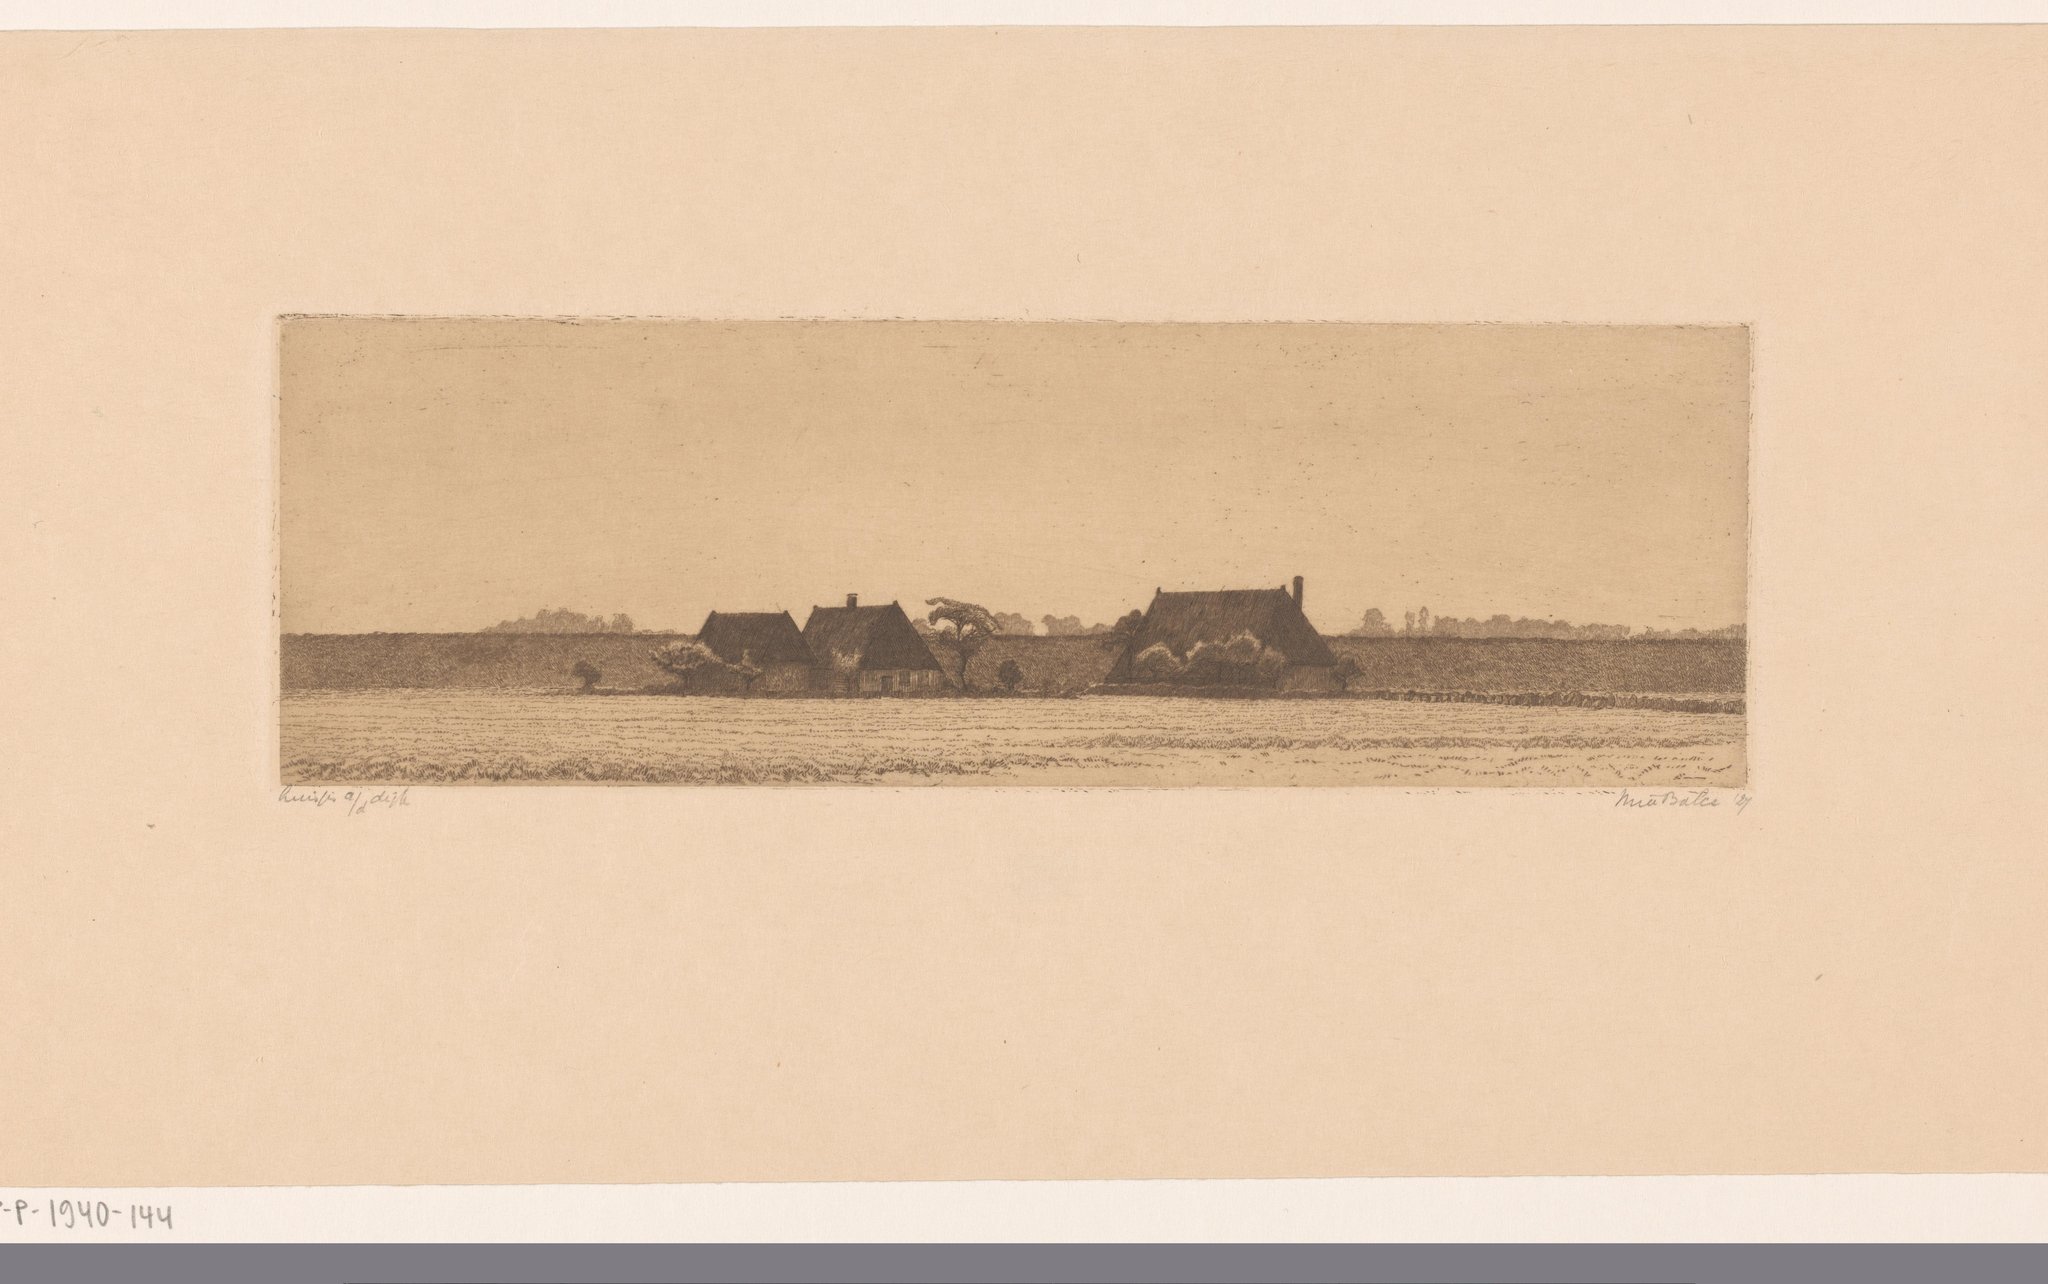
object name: print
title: Huisjes aan de dijk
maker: mia bake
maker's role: draughtsman, print maker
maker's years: 1886-1939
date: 1927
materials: paper, ink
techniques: aquatint, drypoint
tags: dikes, levee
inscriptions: signature and date: ‘Mia Bake ´27’, title: ‘huisjes a/d dijk’, collector's mark: Lugt 2228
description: Vlak landschap met drie huizen tegen een dijk.